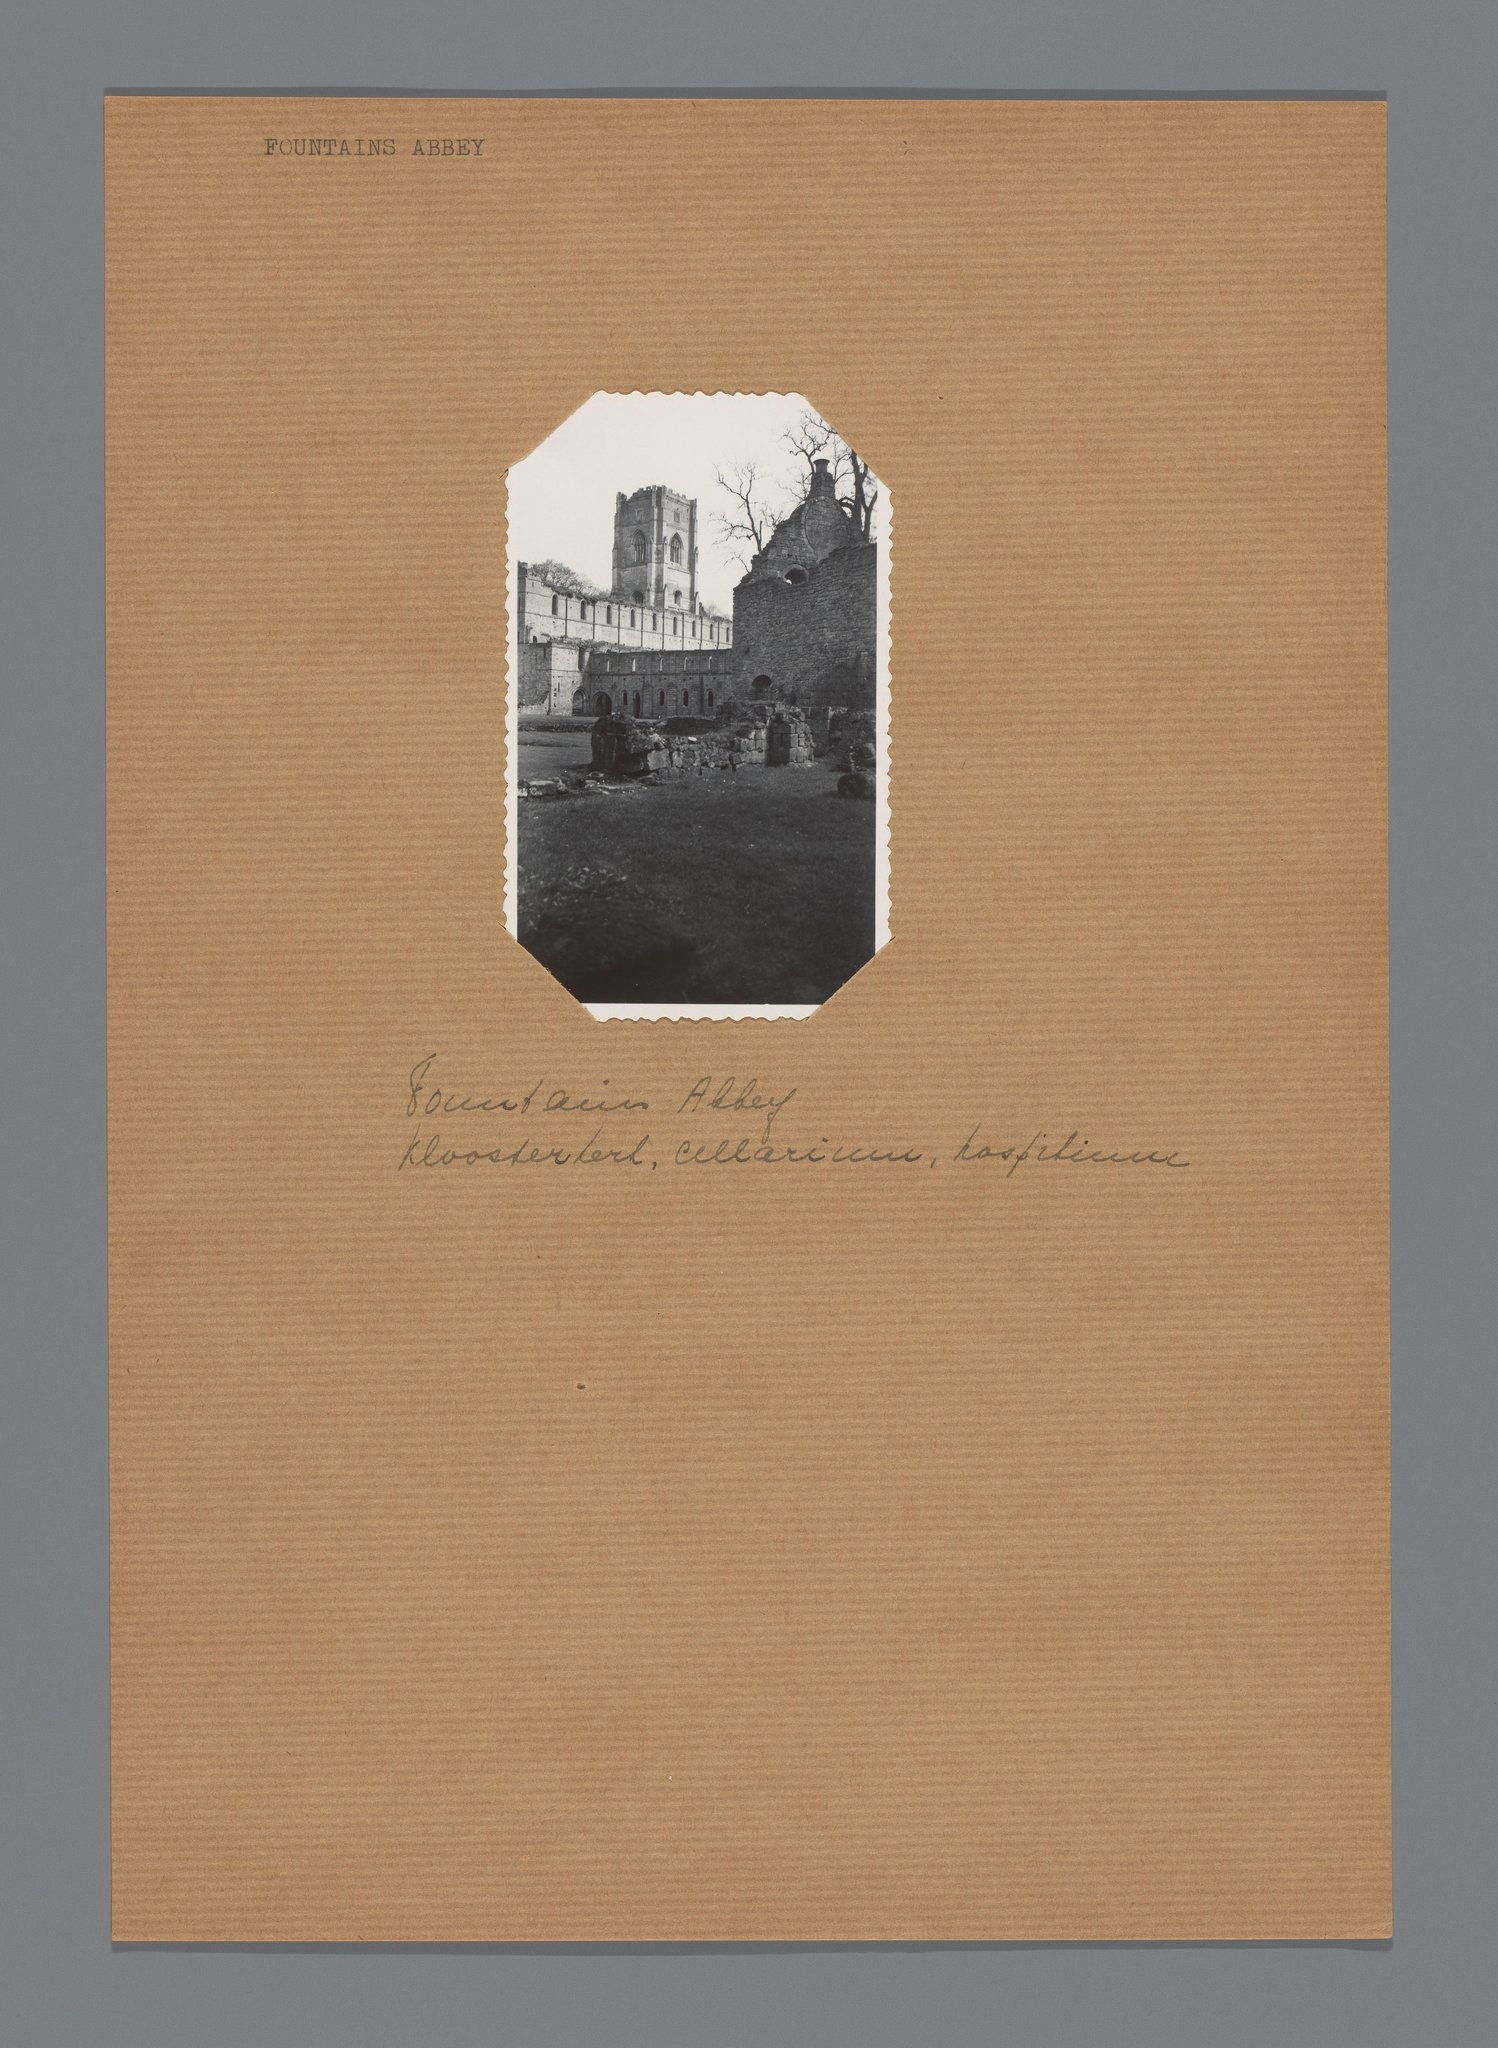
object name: photograph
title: England. Fountains Abbey.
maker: Anonymous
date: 1880-1920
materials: photographic support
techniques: gelatin silver print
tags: fountains abbey